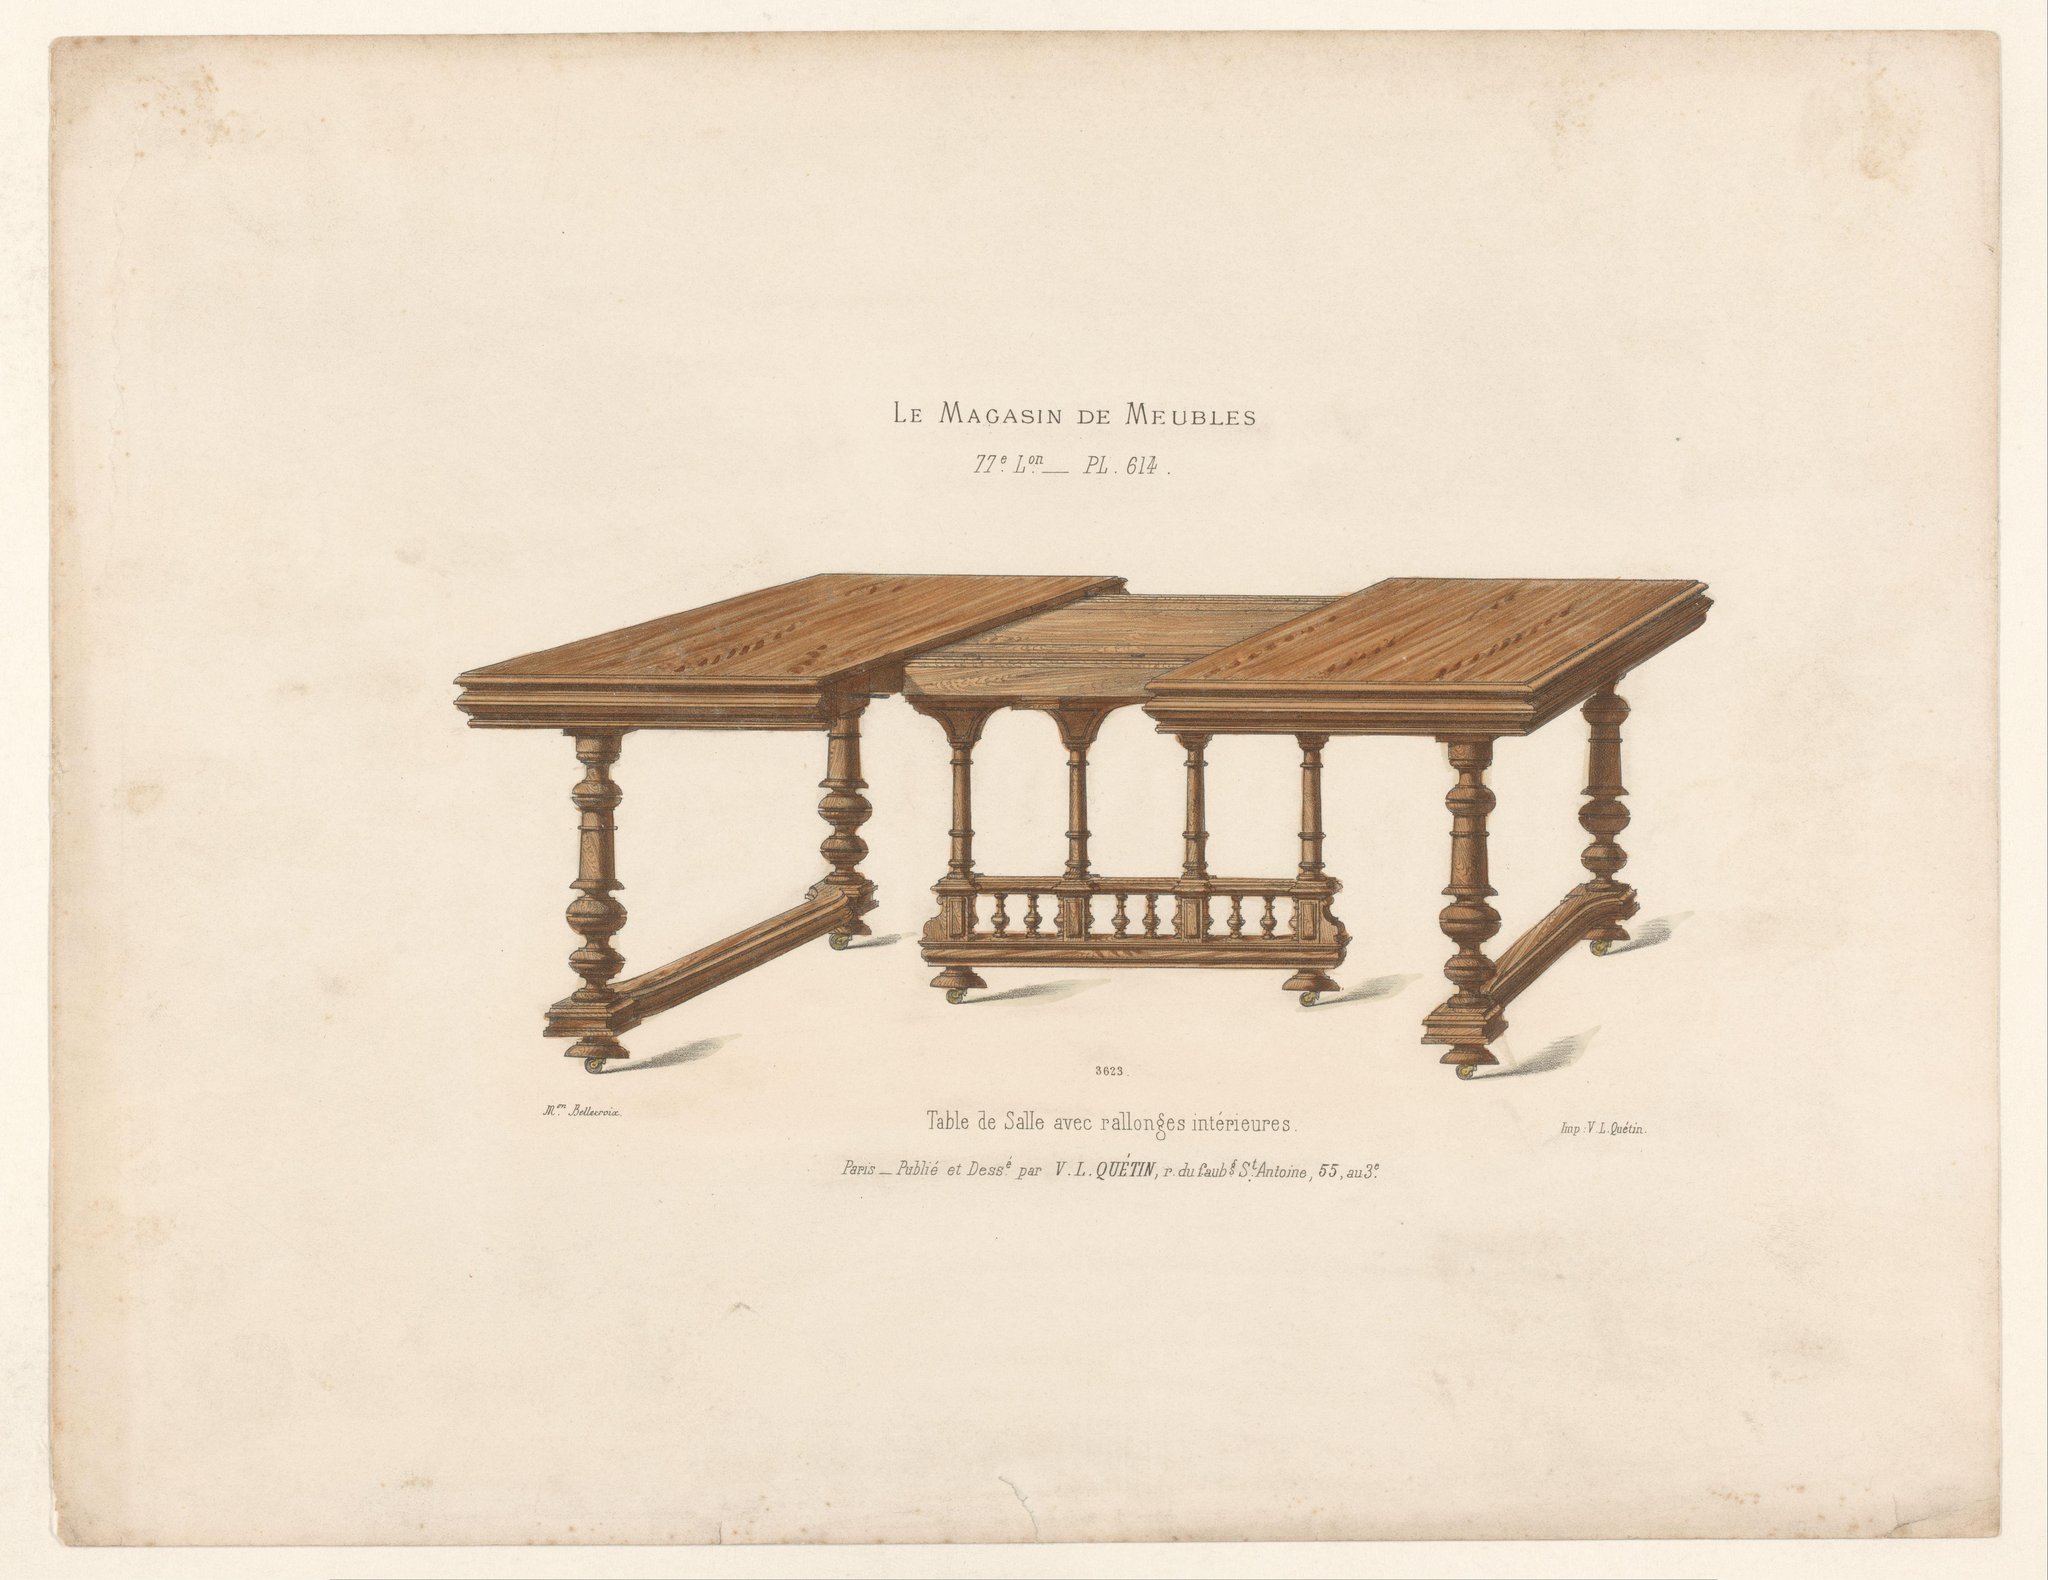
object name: print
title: Eettafel met intern verlengstuk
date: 1878-1904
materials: paper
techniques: hand coloring, lithograph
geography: paris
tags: table